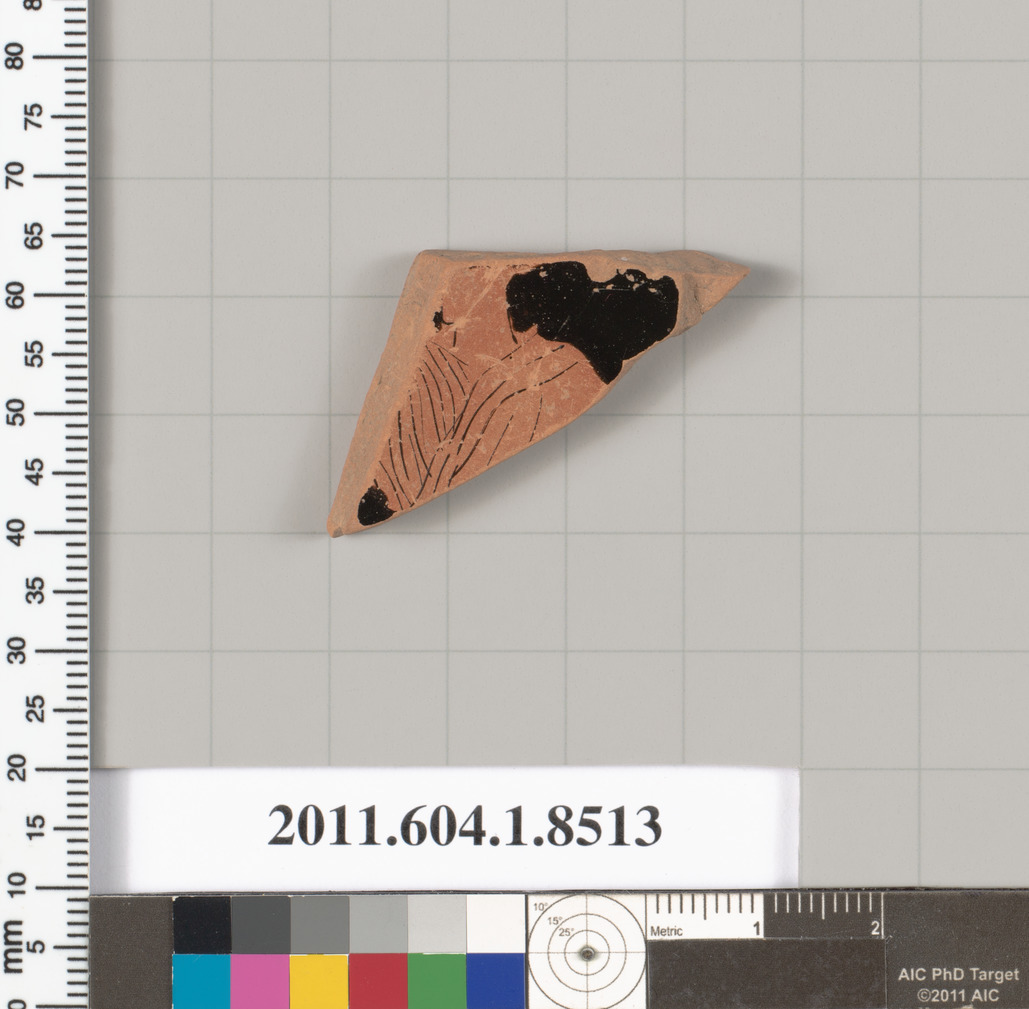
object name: kylix fragment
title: Terracotta fragment of a stemless kylix (drinking cup)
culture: greek, attic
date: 460-450 BCE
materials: terracotta